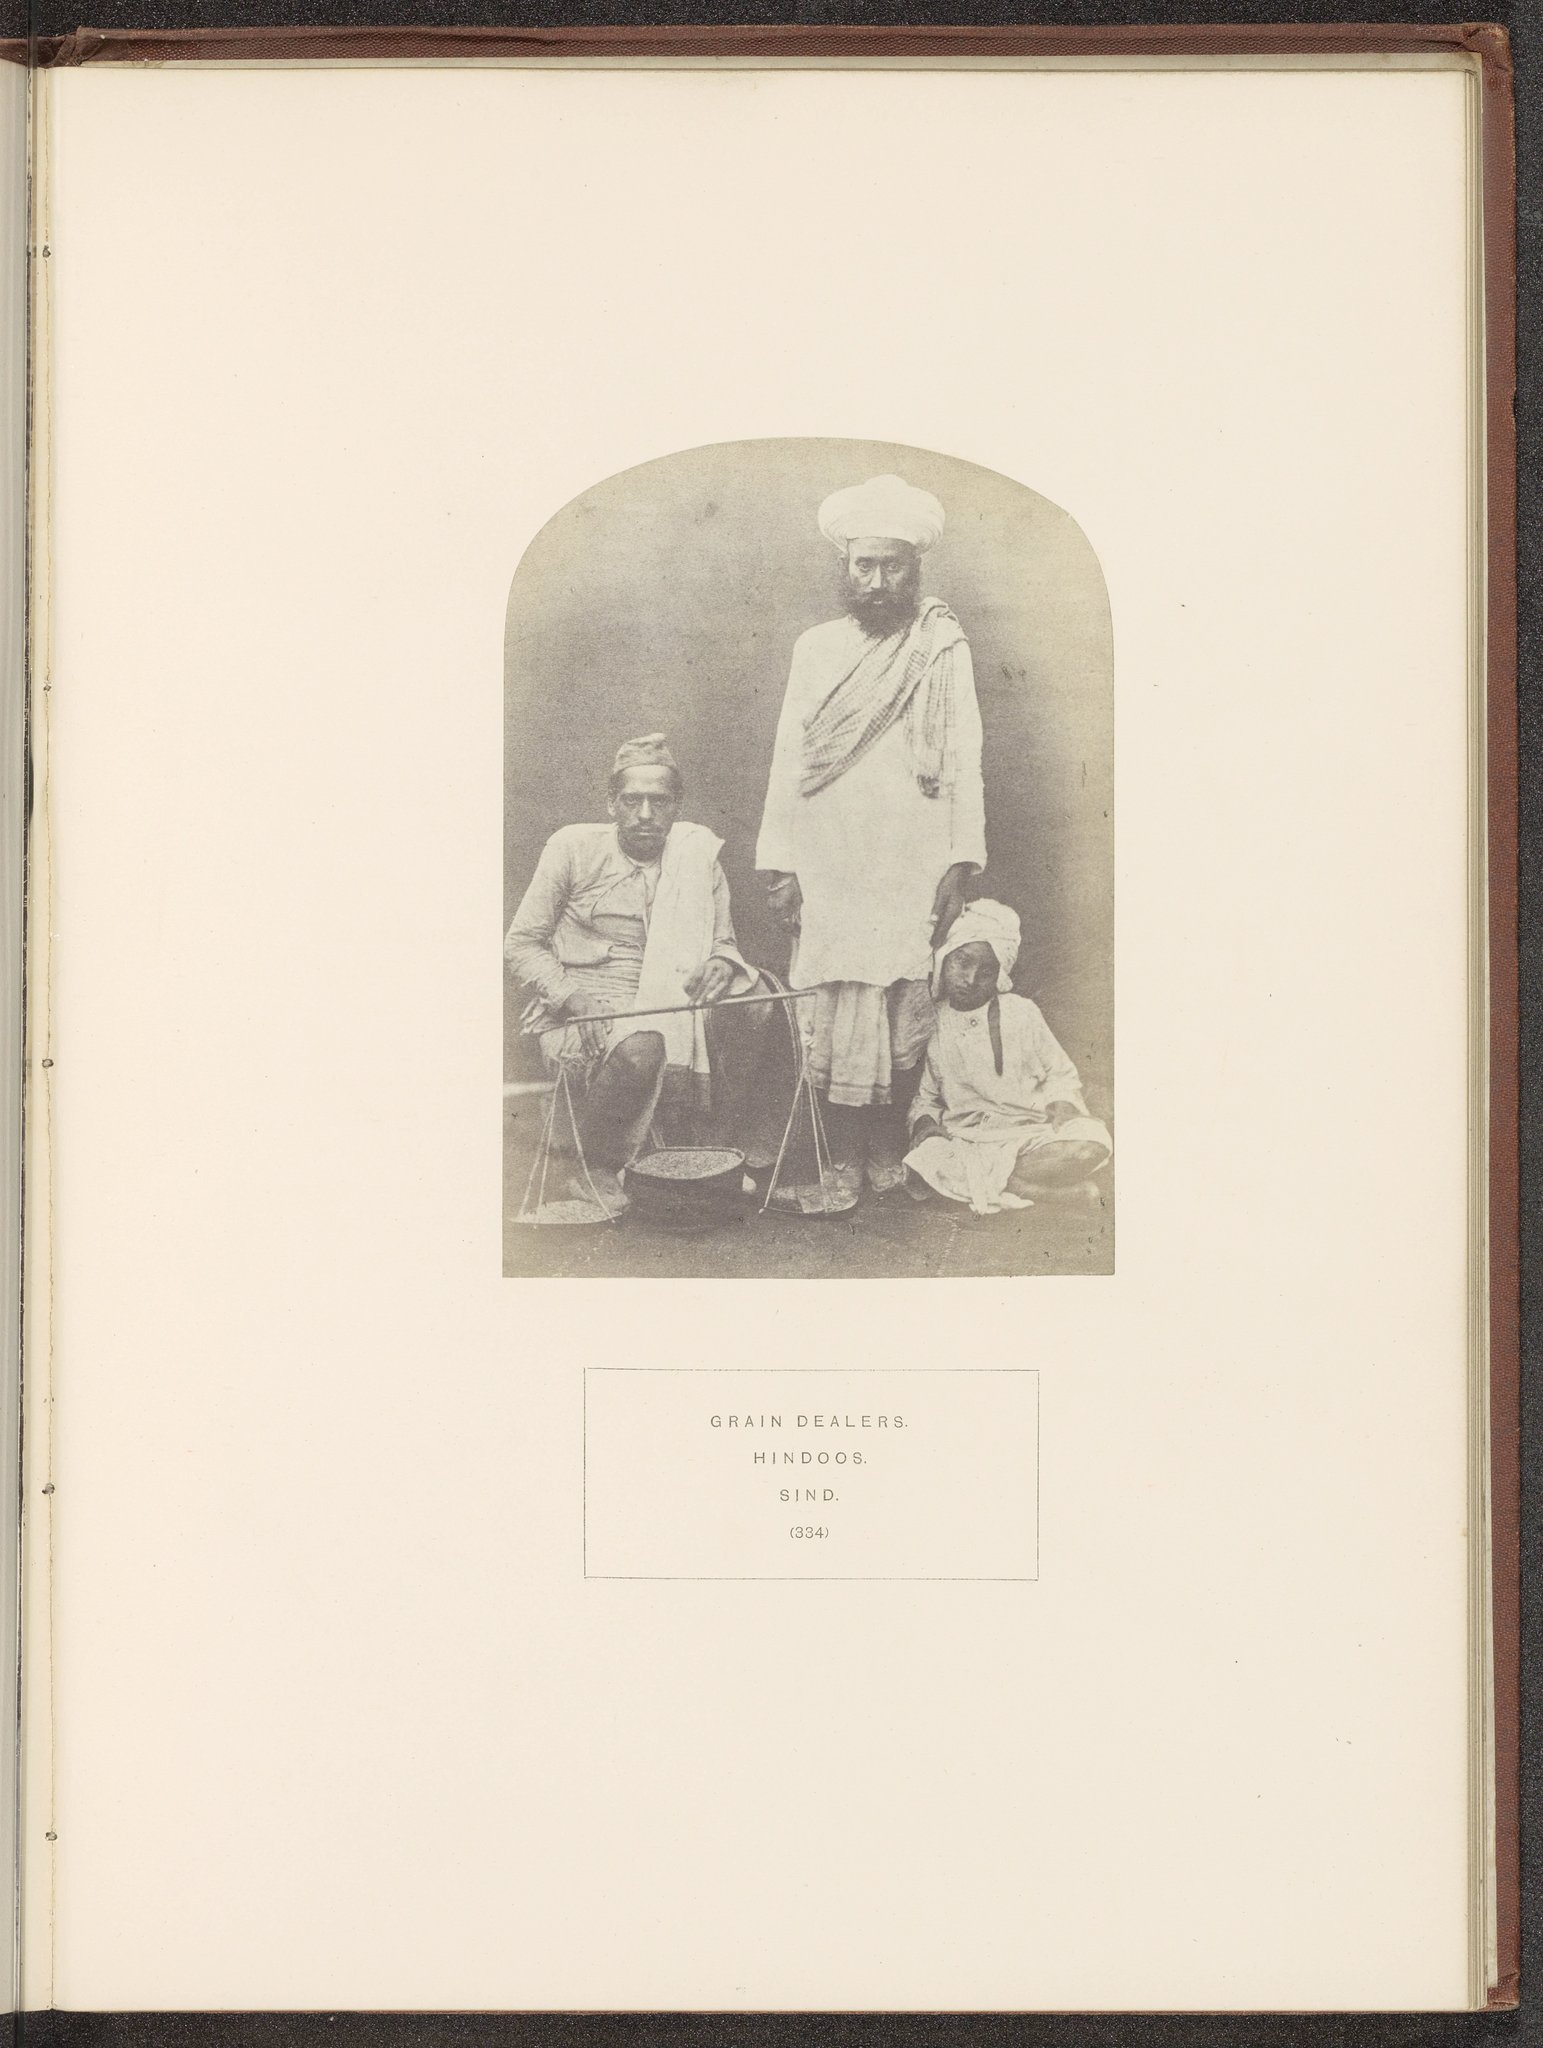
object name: photograph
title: Portrait of three unknown grain dealers in Sindh, Pakistan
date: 1862-1872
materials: photographic support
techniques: albumen print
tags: human races; peoples; nationalities, merchant, salesman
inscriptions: inscription: ‘GRAIN DEALERS./ HINDOOS./ SIND.’, number: ‘(334)’